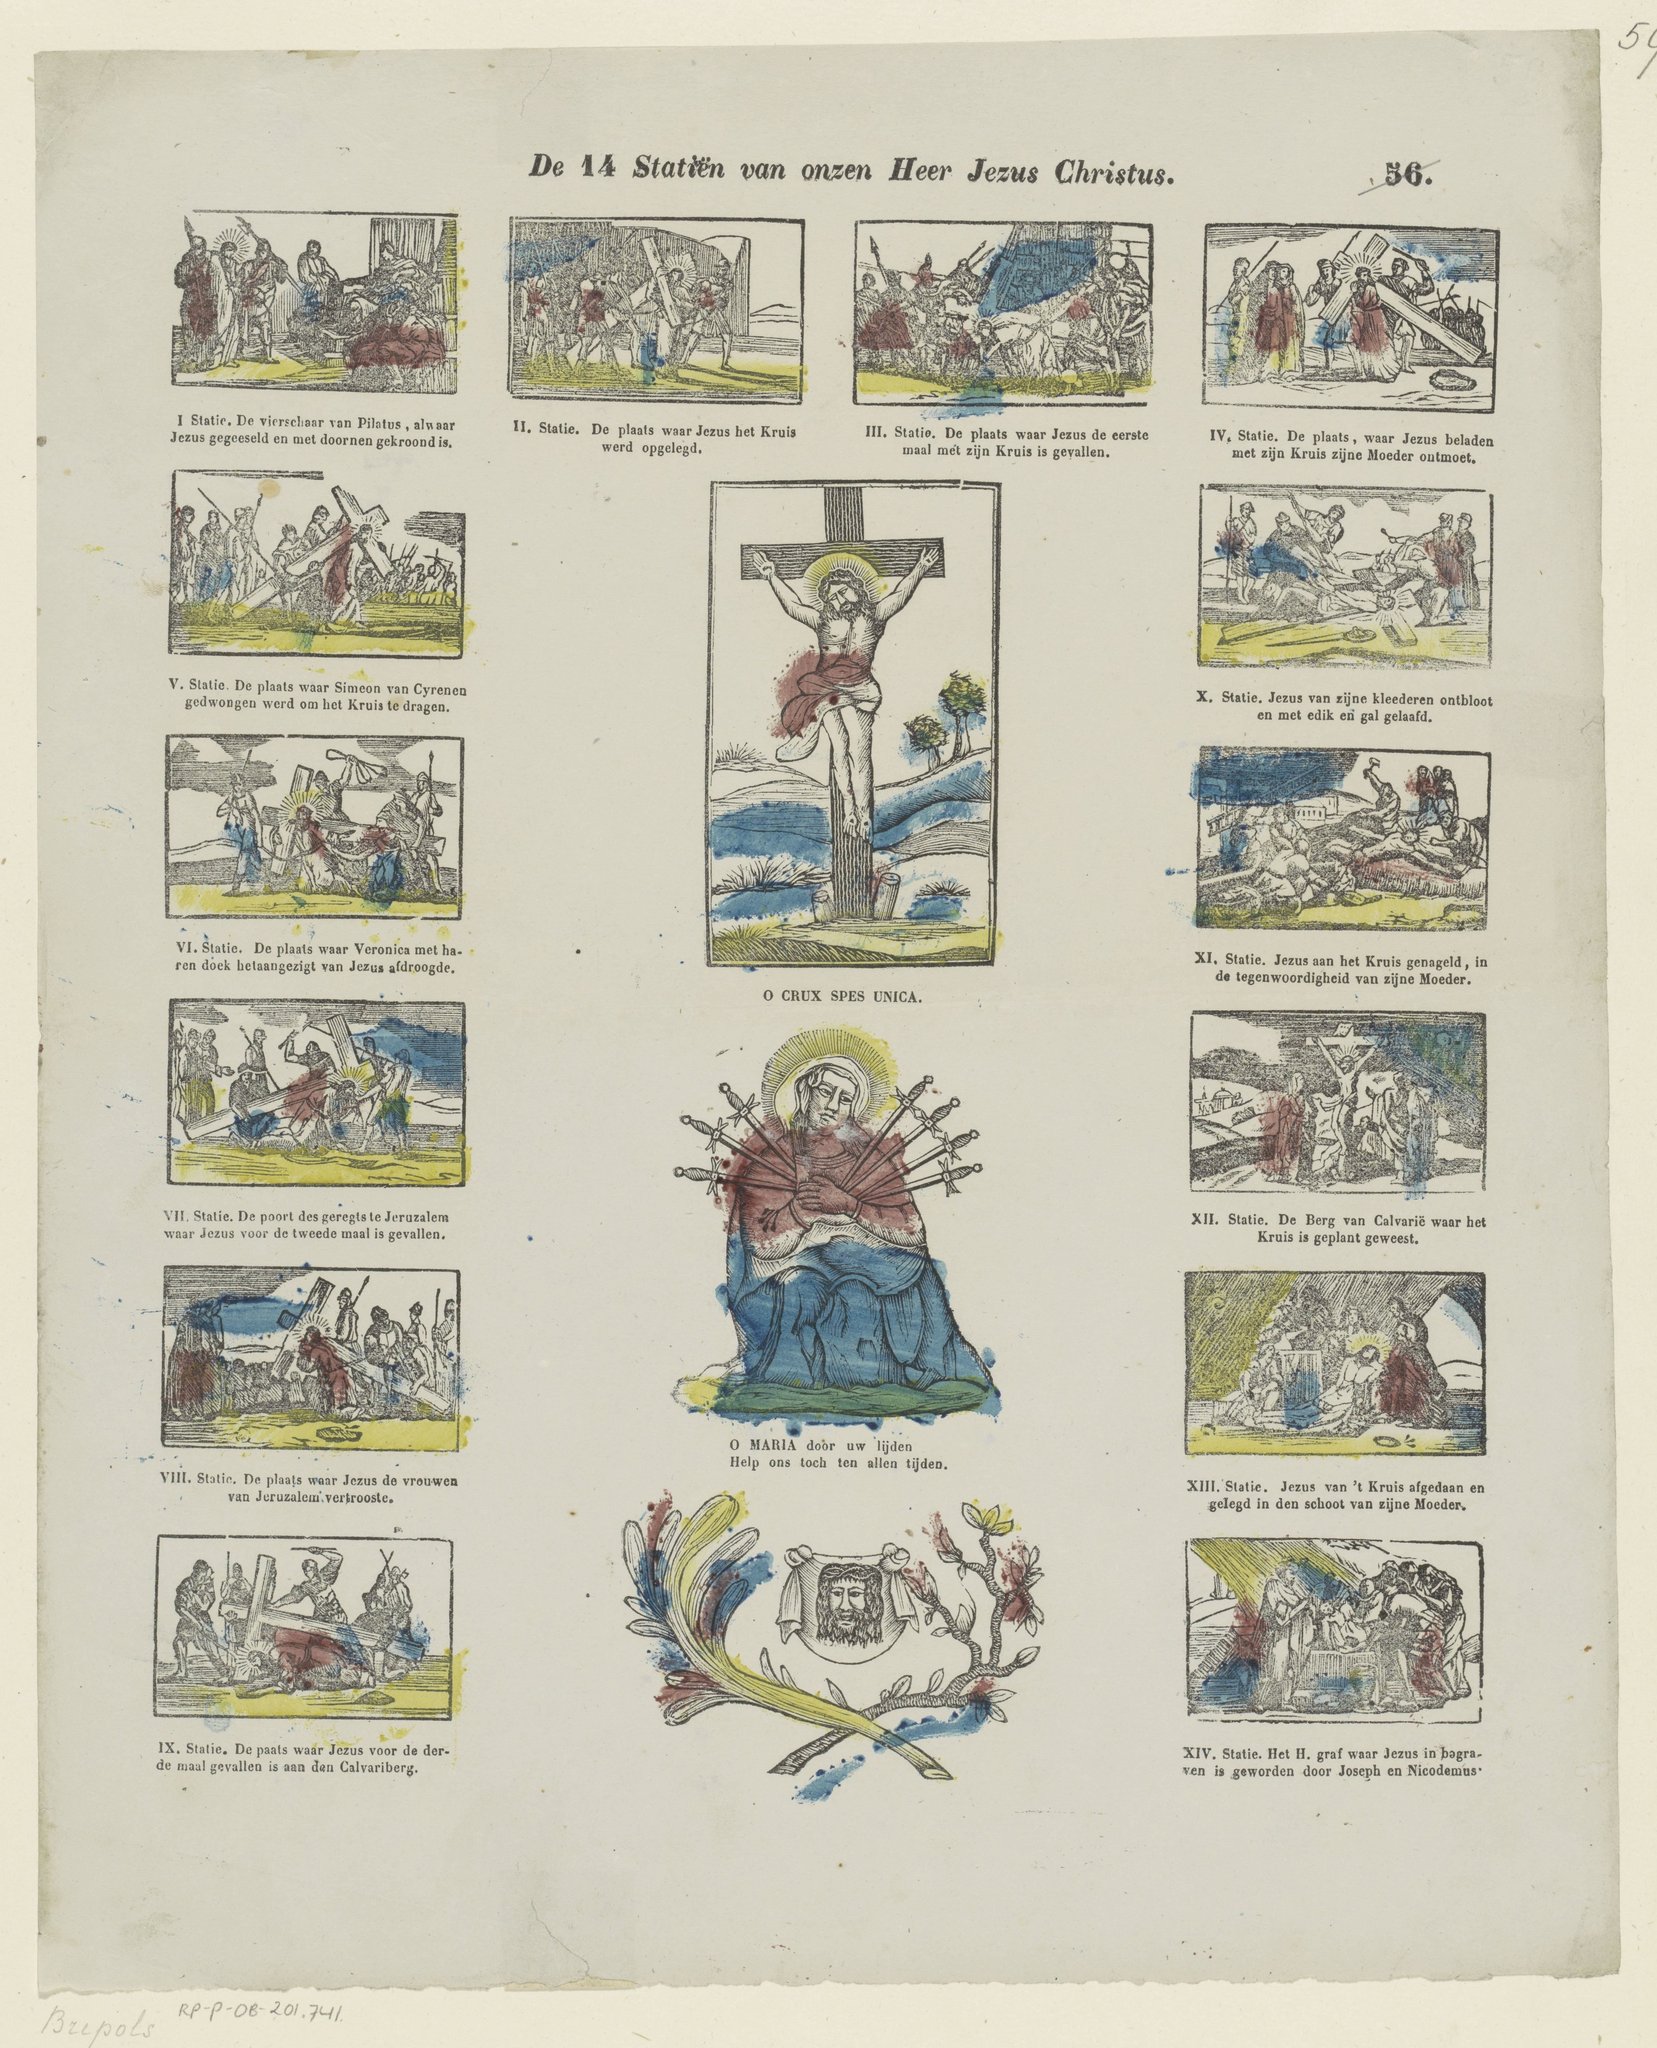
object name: popular print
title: De veertien statiën van onzen heer Jezus Christus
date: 1800-1833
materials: paper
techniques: colour, letterpress printing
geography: turnhout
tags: shroud ~ instruments of the passion, series of scenes from the life of christ, passion of christ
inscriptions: collector's mark: Lugt 2760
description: Blad met 17 voorstellingen van de Passie van Christus, de kruisafname, de graflegging en de zweetdoek van Veronica met de beeldtenis van Christus. in het Nederlands. Onder elke voorstelling een onderschrift. Genummerd rechtsboven: 56.